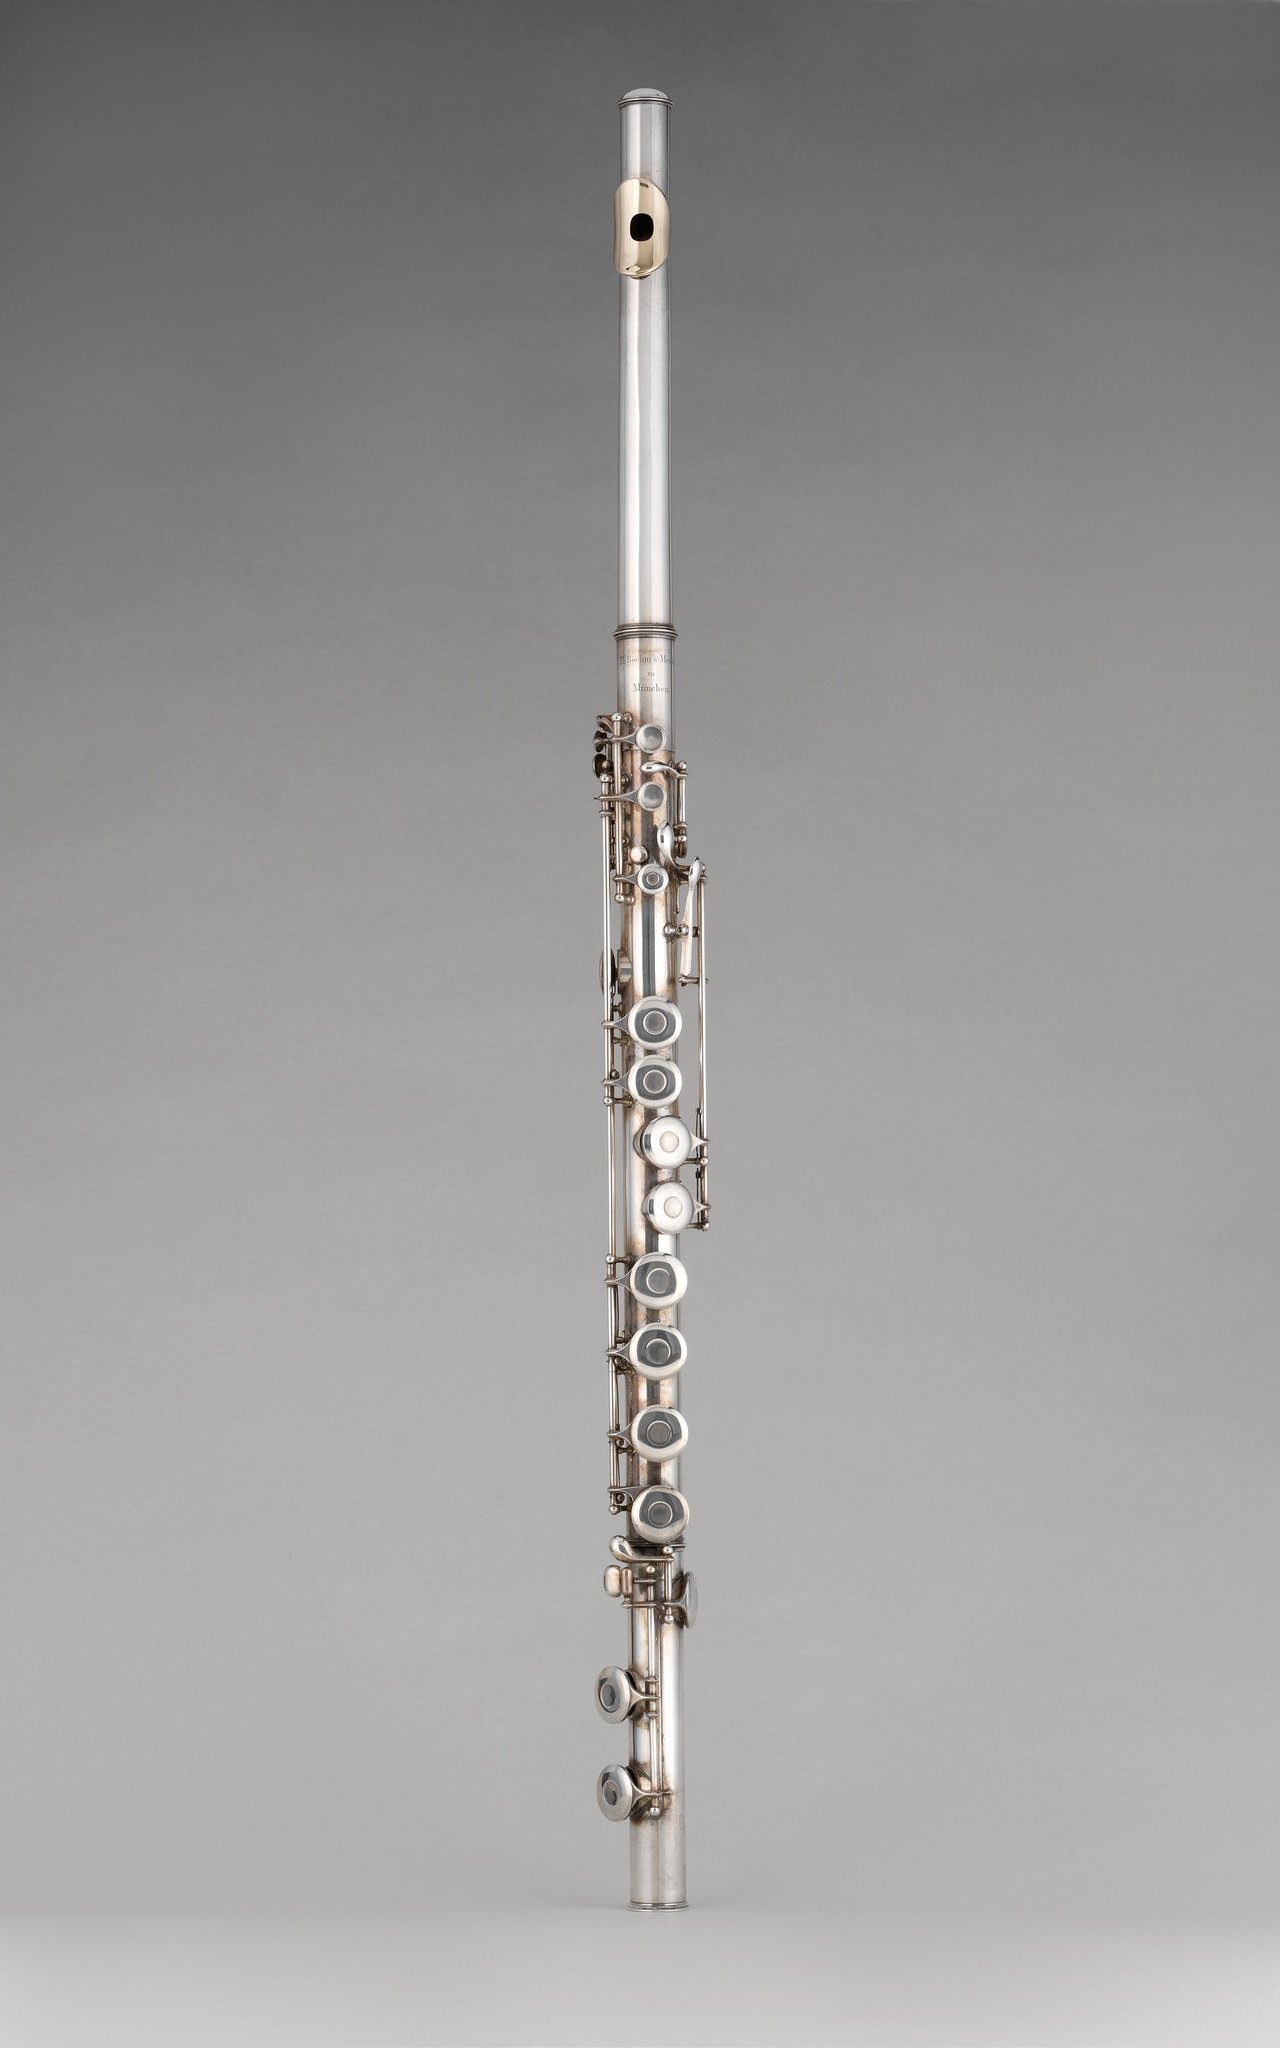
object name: alto flute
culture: german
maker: boehm & mendler, german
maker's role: maker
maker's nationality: german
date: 1880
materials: gold, silver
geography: germany